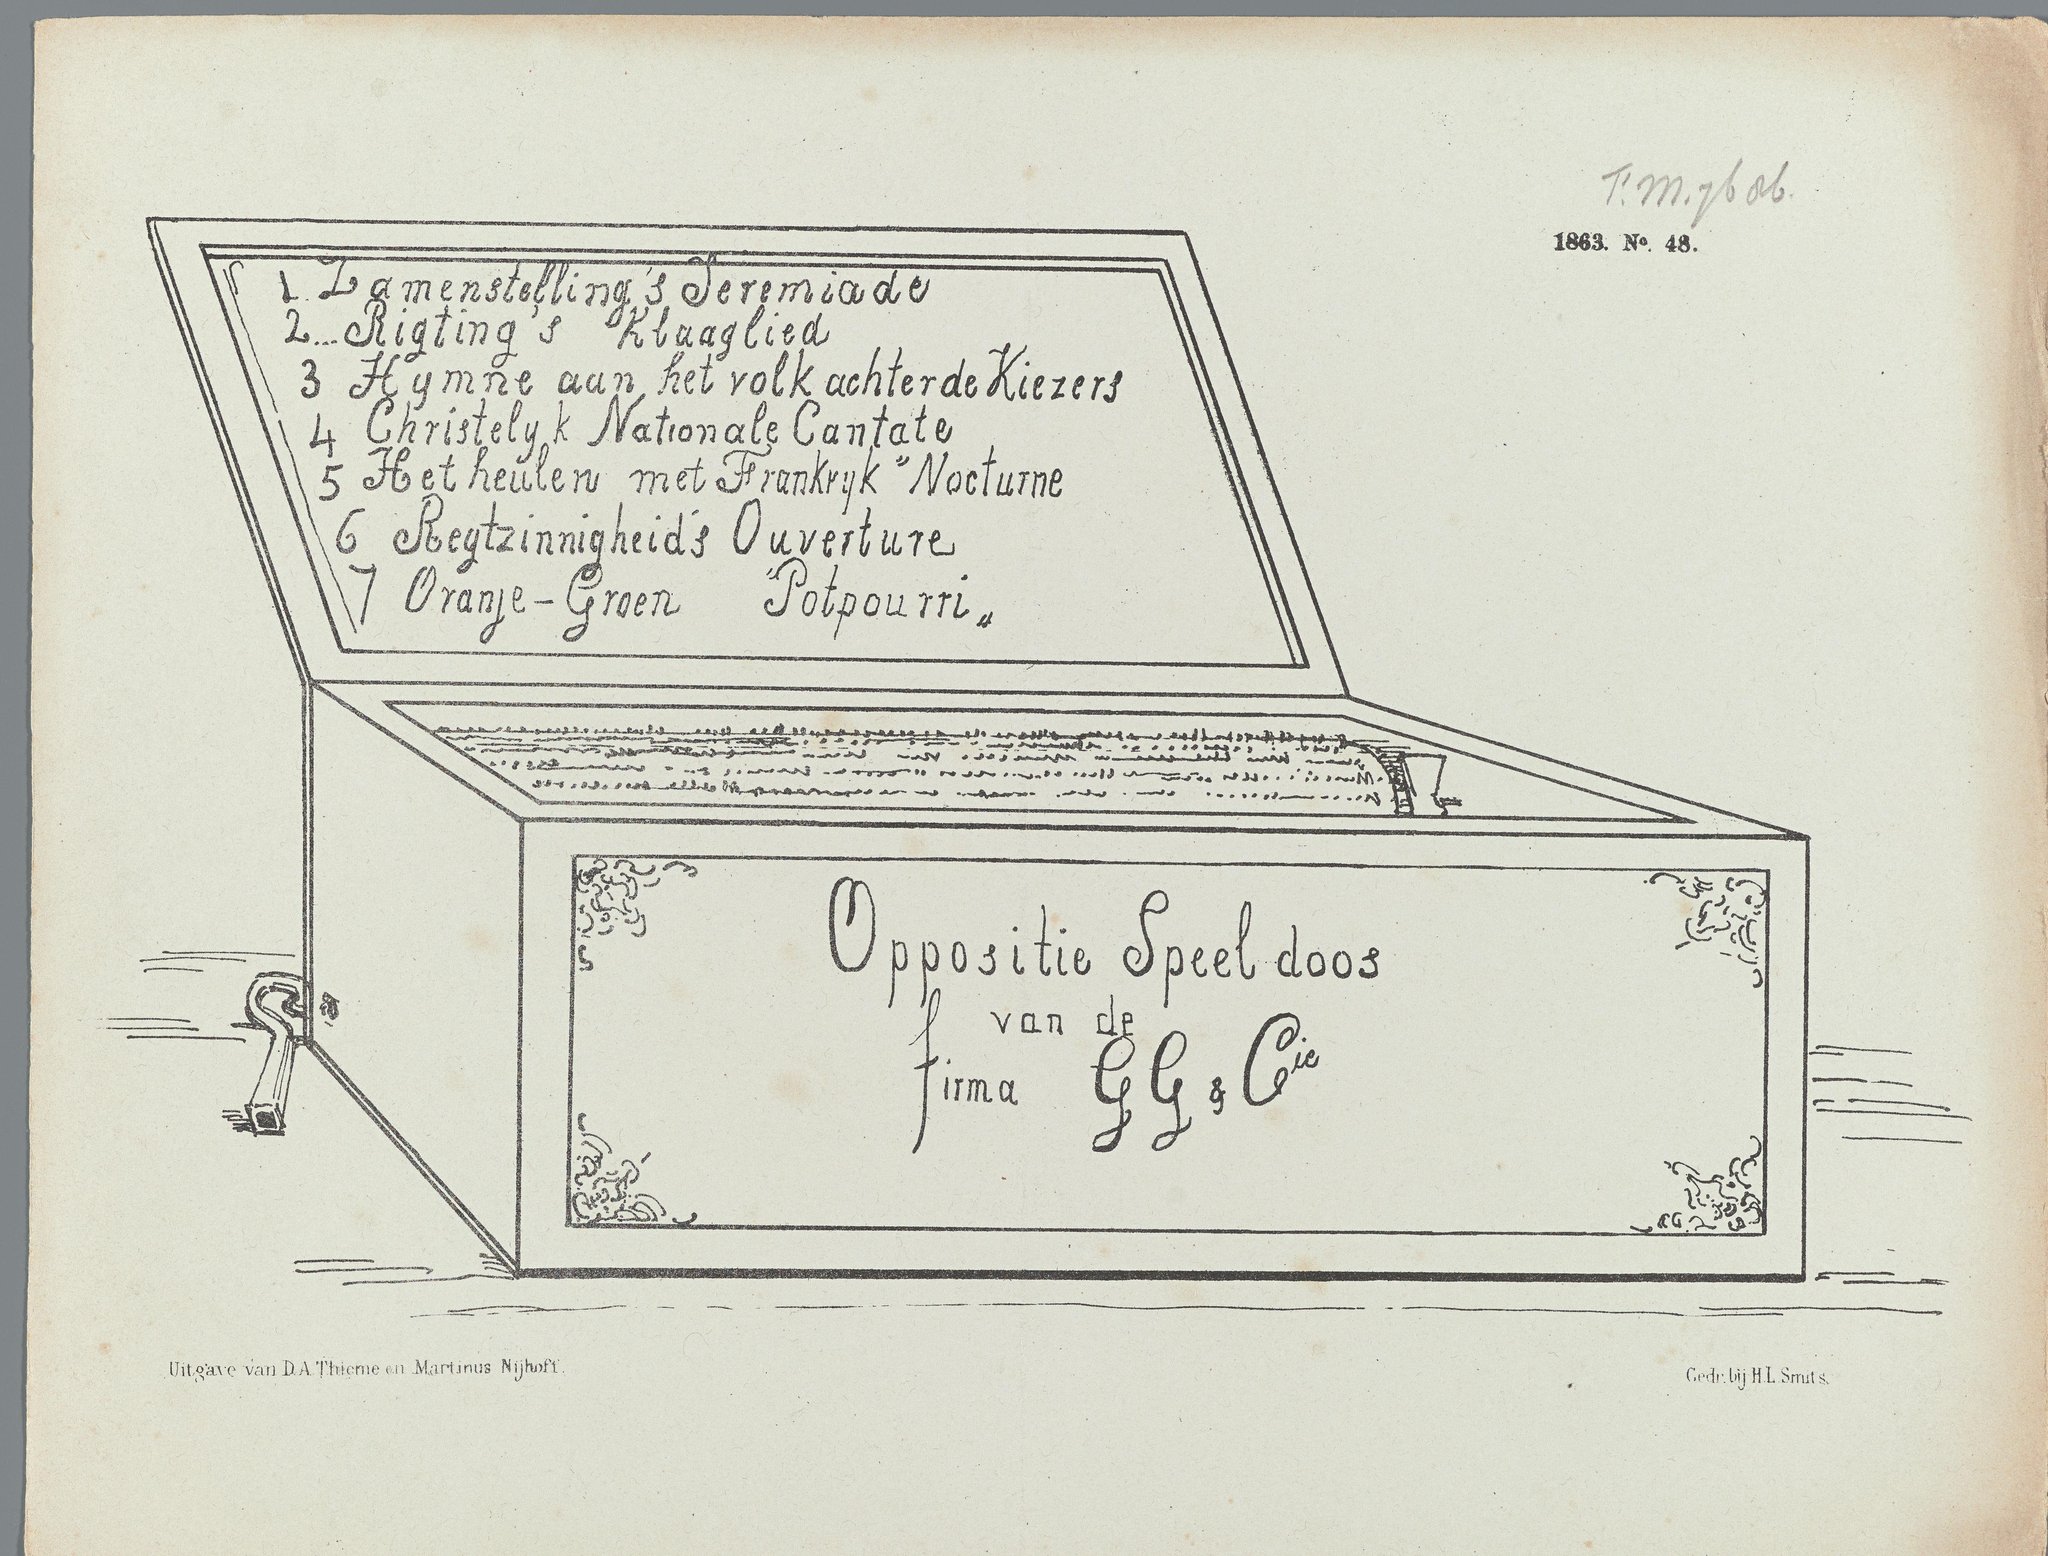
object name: cartoon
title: Oppositie Speeldoos van de firma GG & Cie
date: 1863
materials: paper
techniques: lithograph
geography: netherlands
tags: guillaume groen van prinsterer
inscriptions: collector's mark: Lugt 2228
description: Spotprent op het programma van de anti-revolutionaire oppositiepartij van Groen van Prinsterer. Muziekdoos met lijst van zeven melodieën in de deksel. Plaat verschenen bij het weekblad De Nederlandsche Spectator, nr. 48, 28 november 1863.